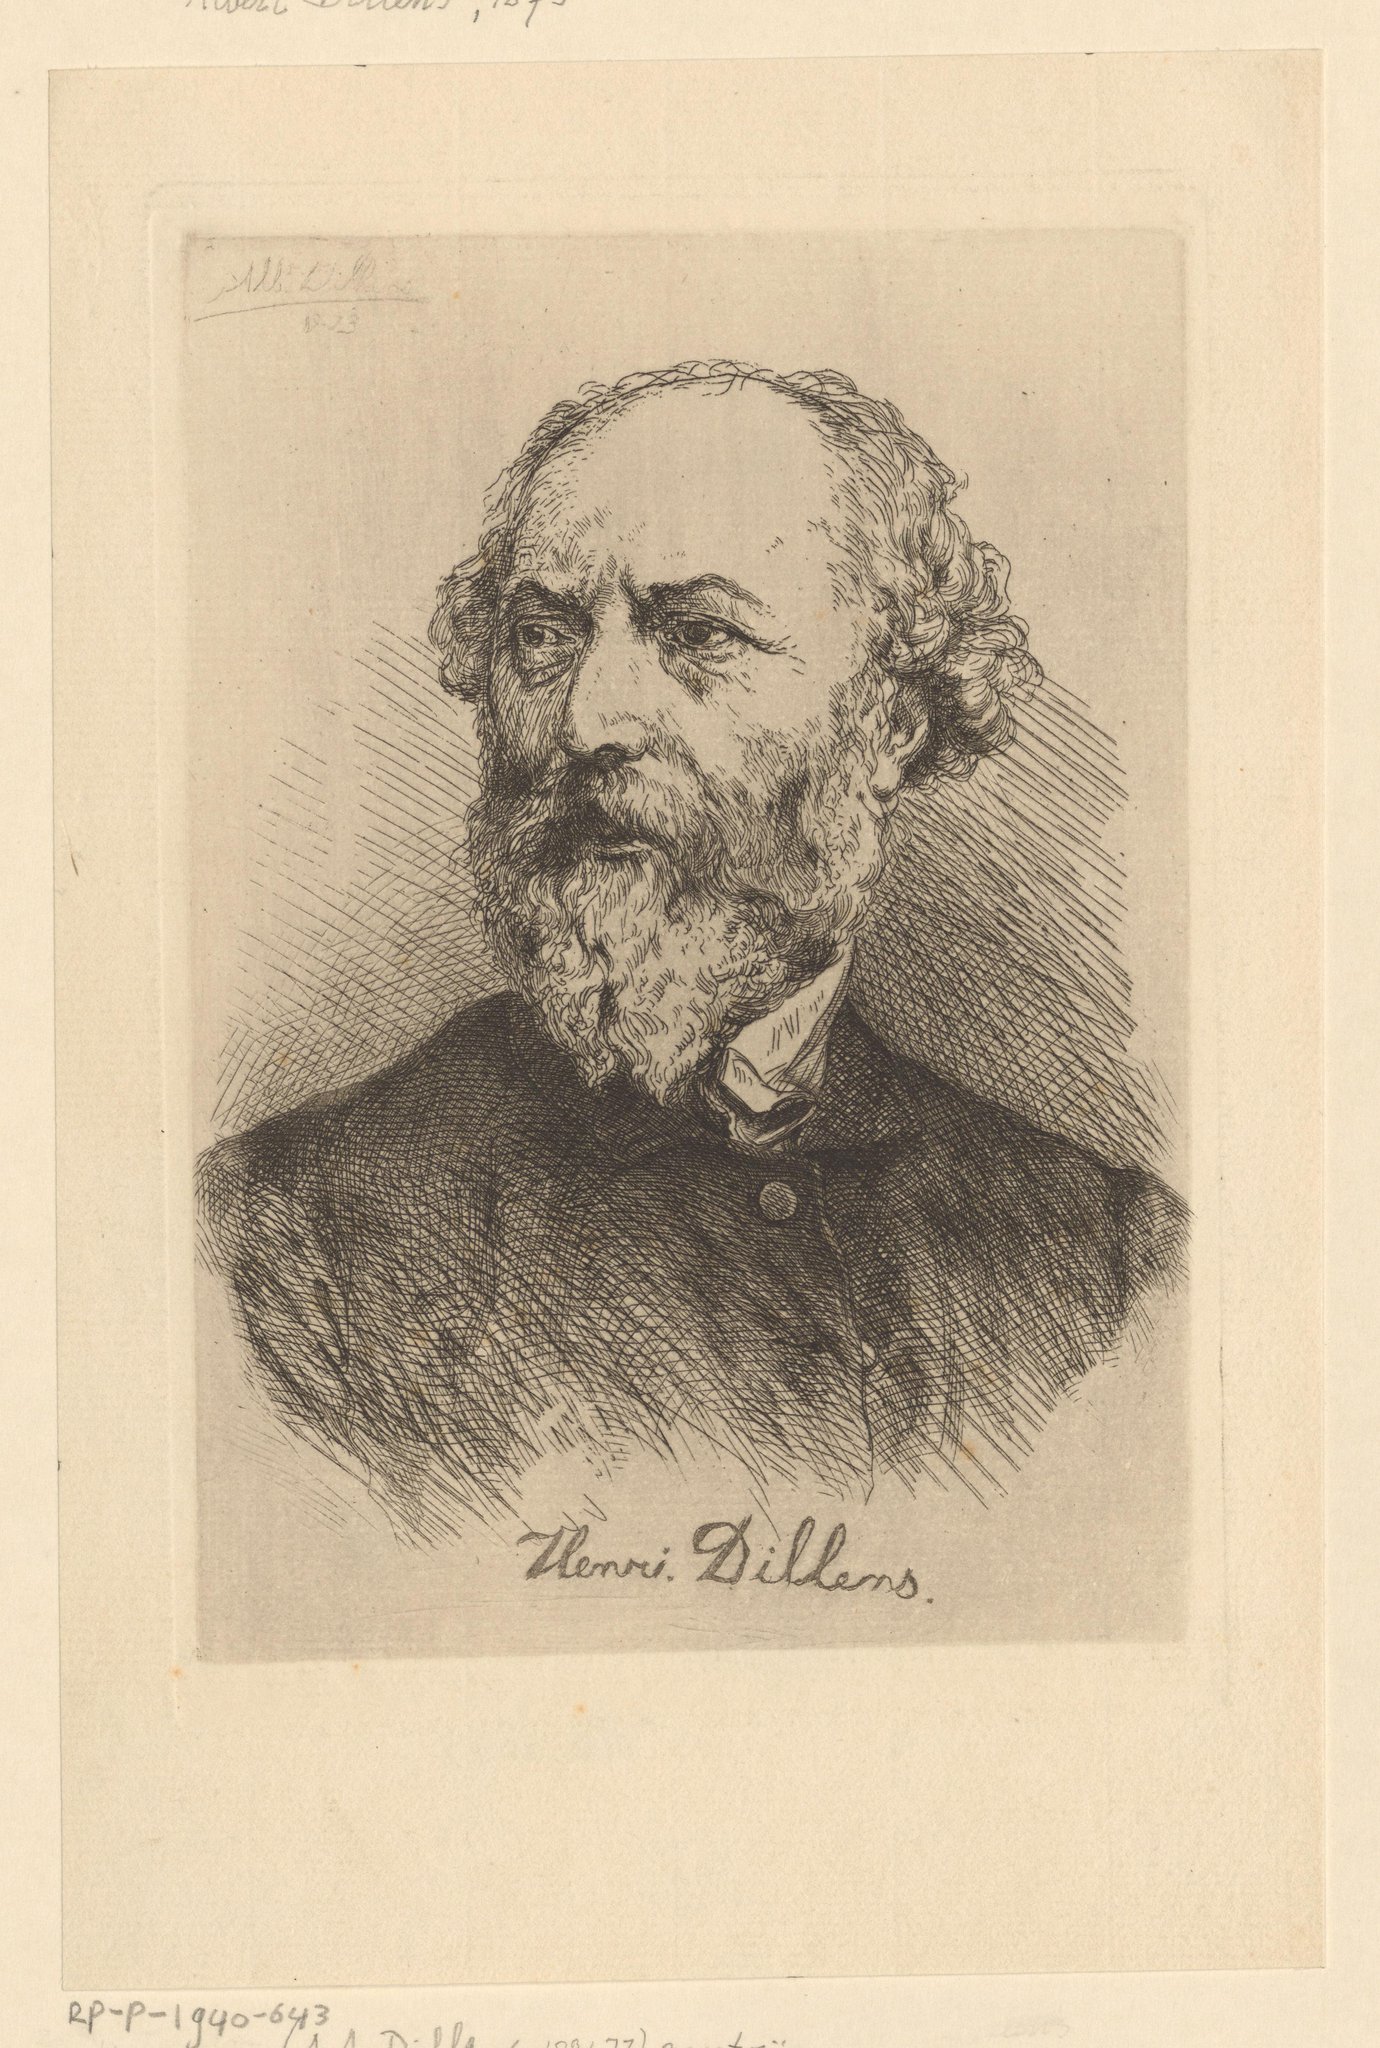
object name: print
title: Portret van Henri Dillens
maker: albert dillens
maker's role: print maker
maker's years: 1844-1915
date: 1873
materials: paper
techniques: etching, intaglio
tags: ghent, brussels, painter, print maker, draughtsman, henri dillens, historical persons, portrait, self-portrait of painter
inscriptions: collector's mark: Lugt 2760, collector's mark: Lugt 2228